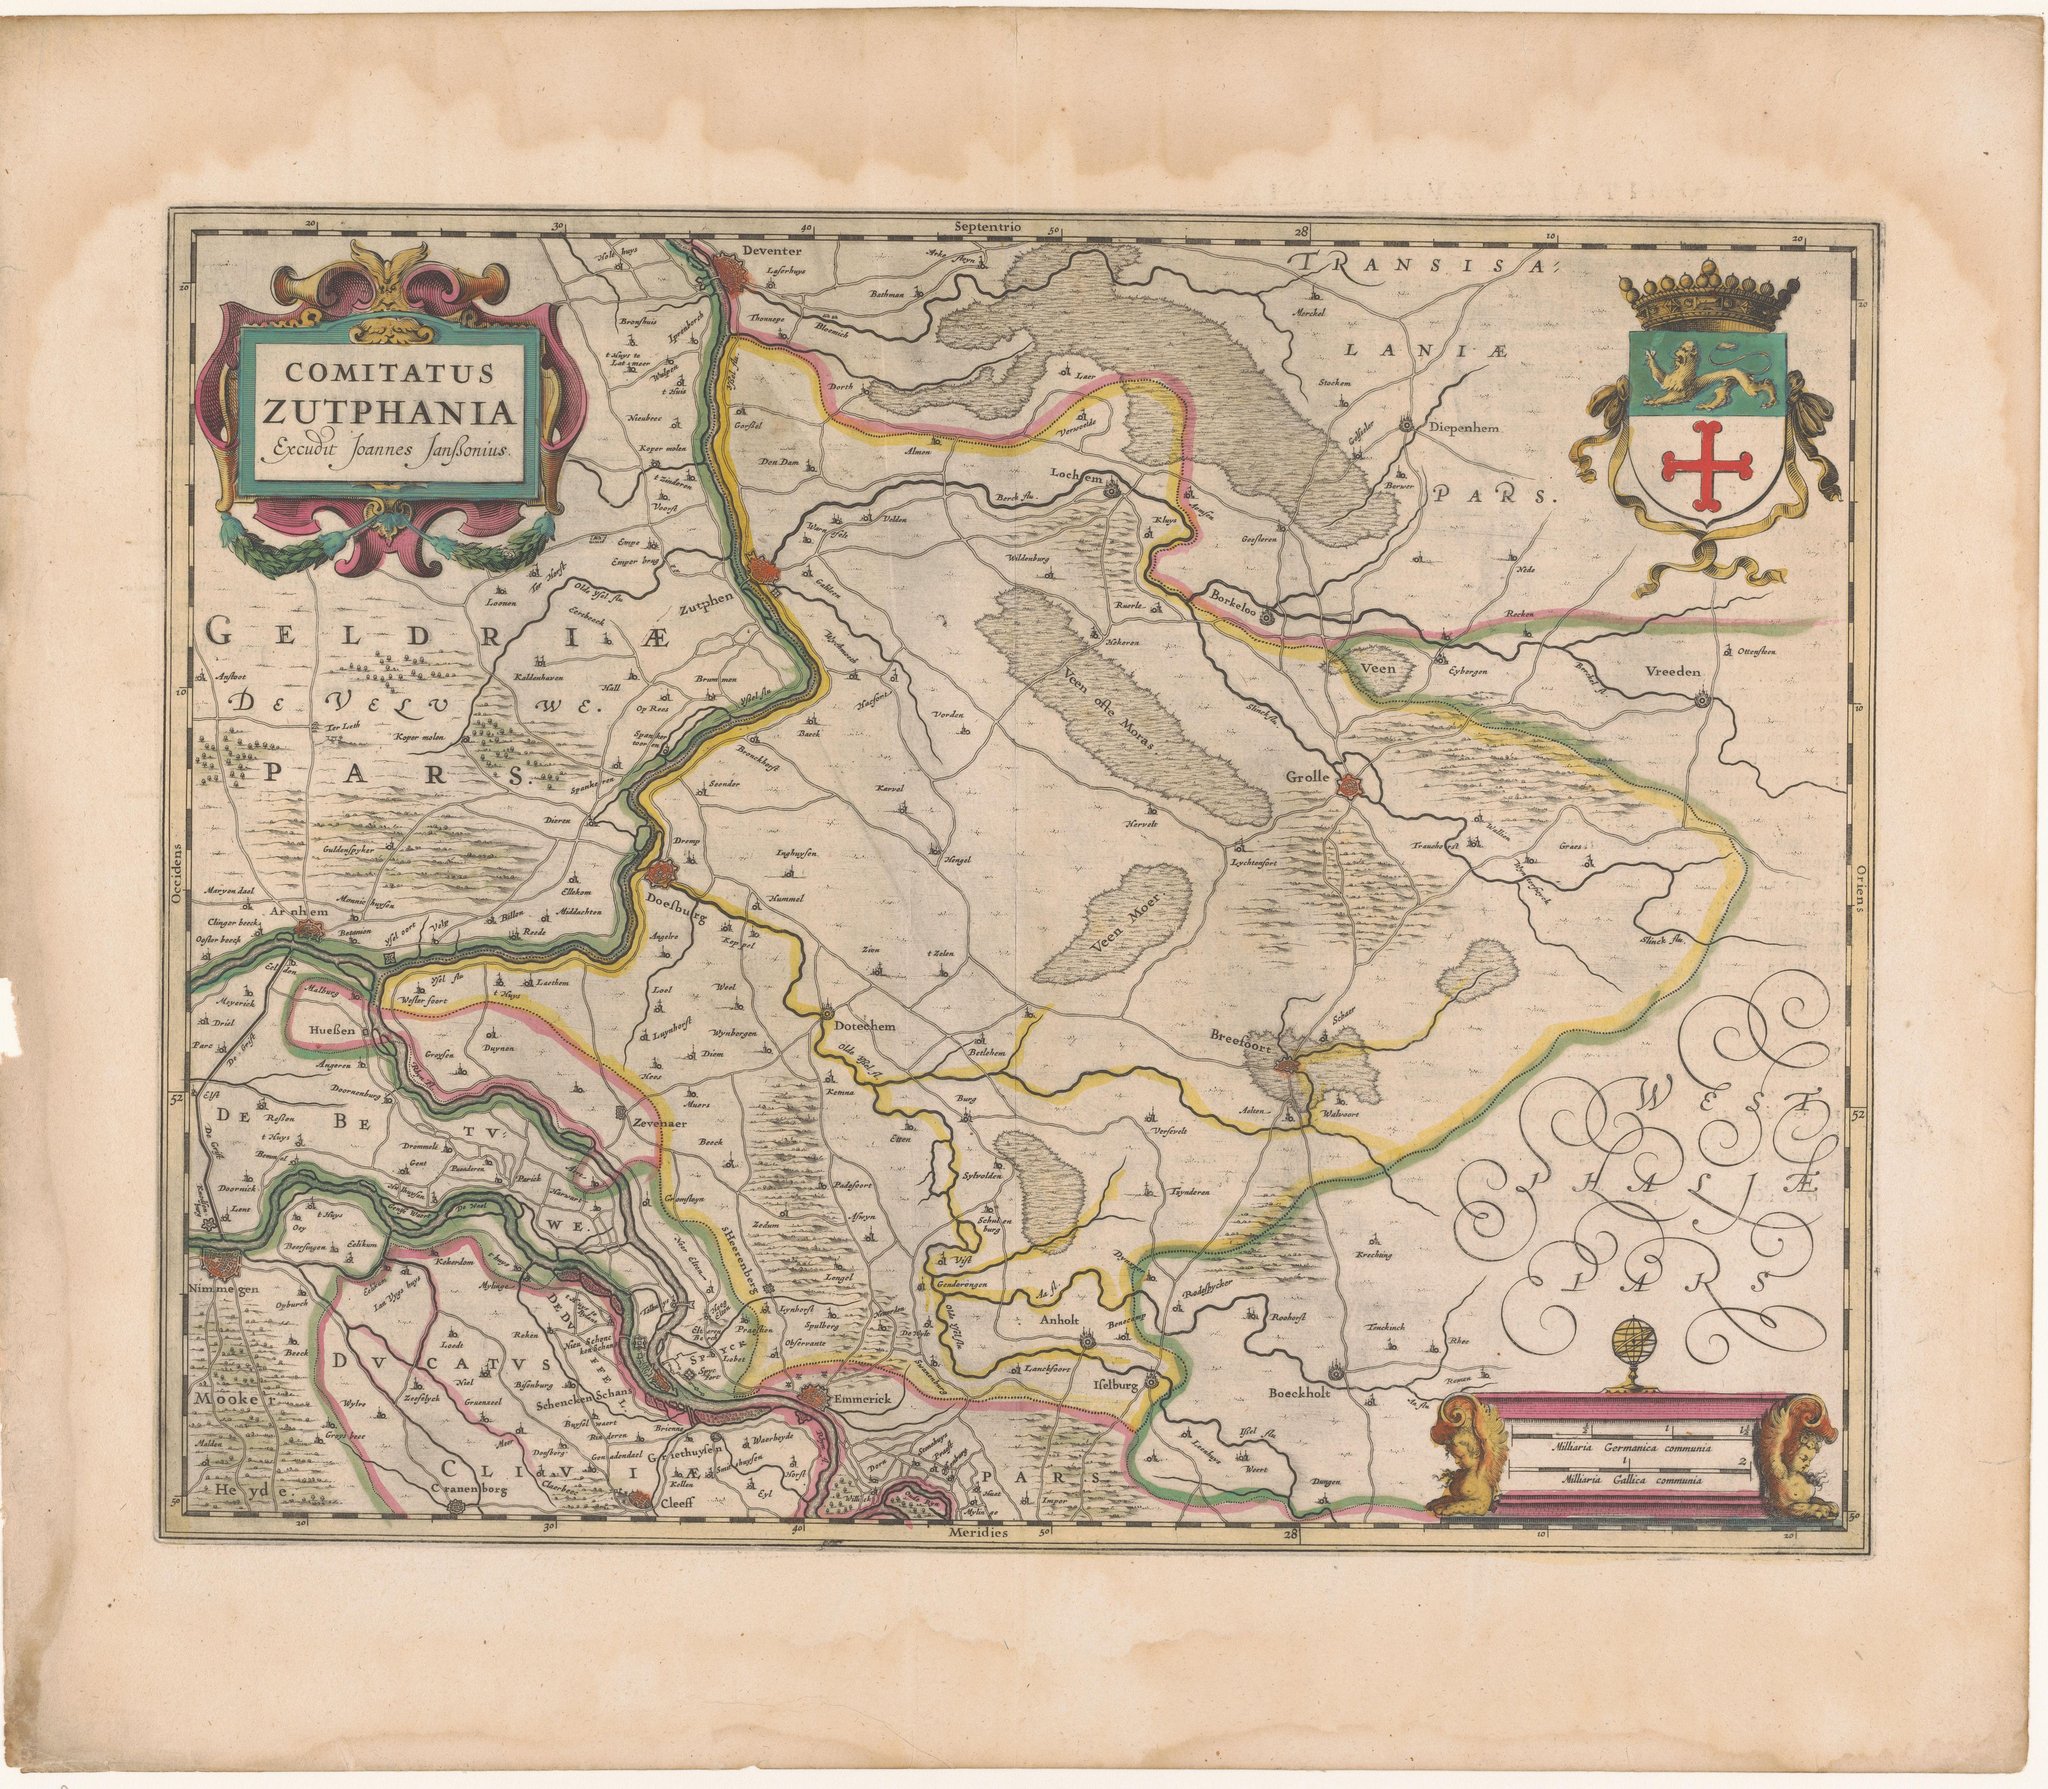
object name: map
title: Kaart van het graafschap Zutphen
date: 1638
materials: paper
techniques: engraving, etching, hand coloring, letterpress printing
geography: amsterdam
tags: coat of arms (as symbol of the state, etc.) (+ city; municipal), maps of separate countries or regions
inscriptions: collector's mark: Lugt 2228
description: Linksboven de titelcartouche. Rechtsonder een cartouche met twee schaalstokken: 1 1/2 Milliaria Germanica communia / 2 Milliaria Gallica communia. Rechtsboven het wapen van de stad Zutphen. Met Latijnse tekst op verso.